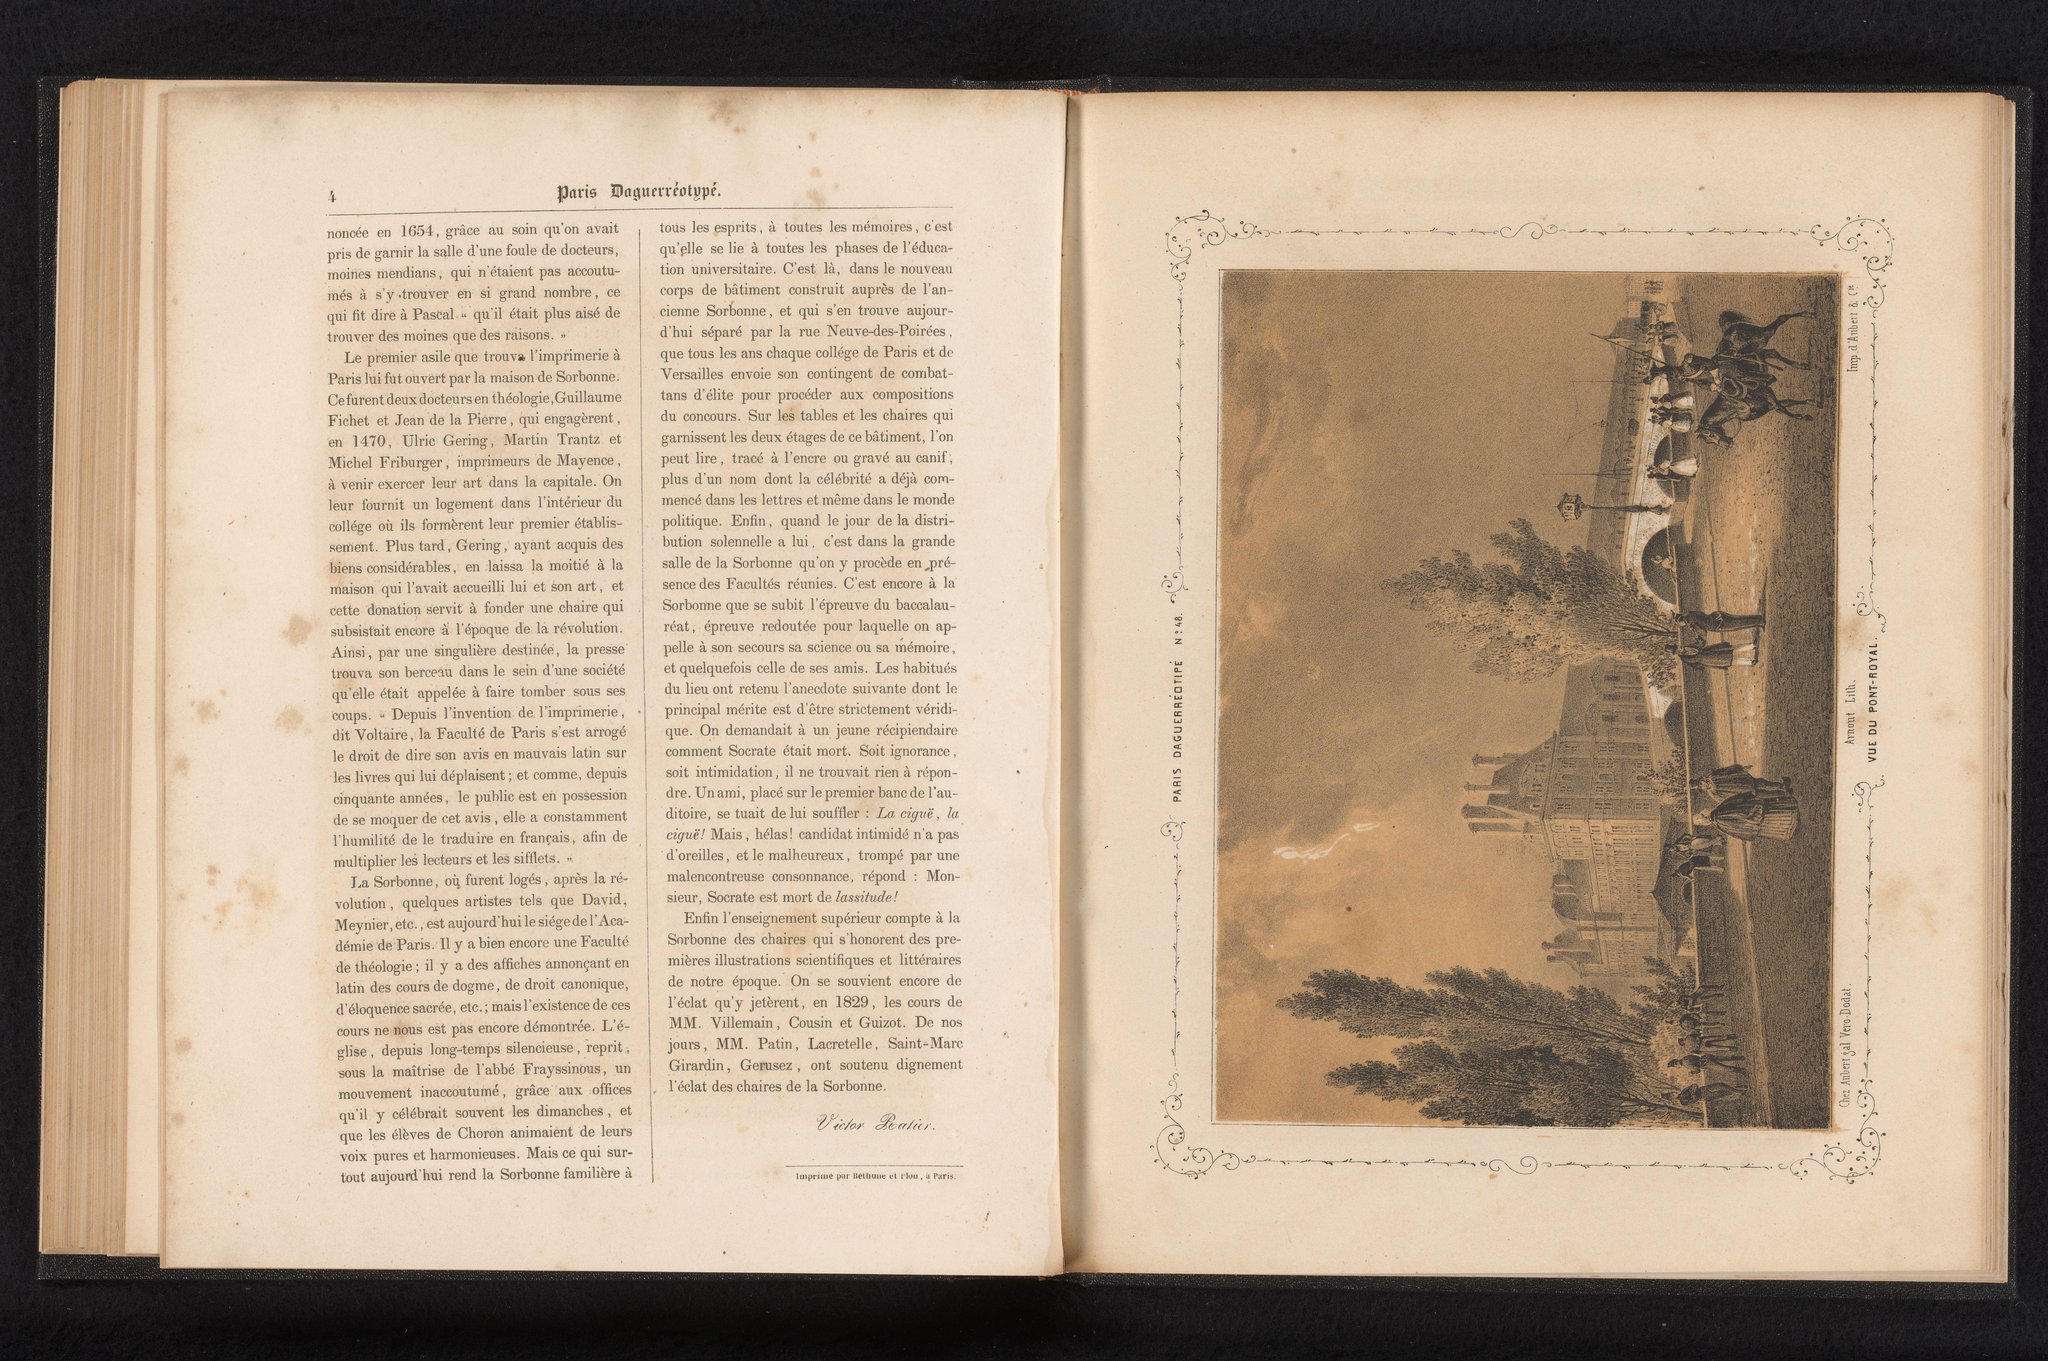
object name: print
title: Gezicht op de Pont Royal in Parijs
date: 1839-1840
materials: paper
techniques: tone lithography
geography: paris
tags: bridge in city across river, canal, etc.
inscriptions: inscription: ‘PARIS DAGUERRÉOTYPÉ No. 48.’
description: Prent op honderdeenennegentigste ongenummerde pagina.